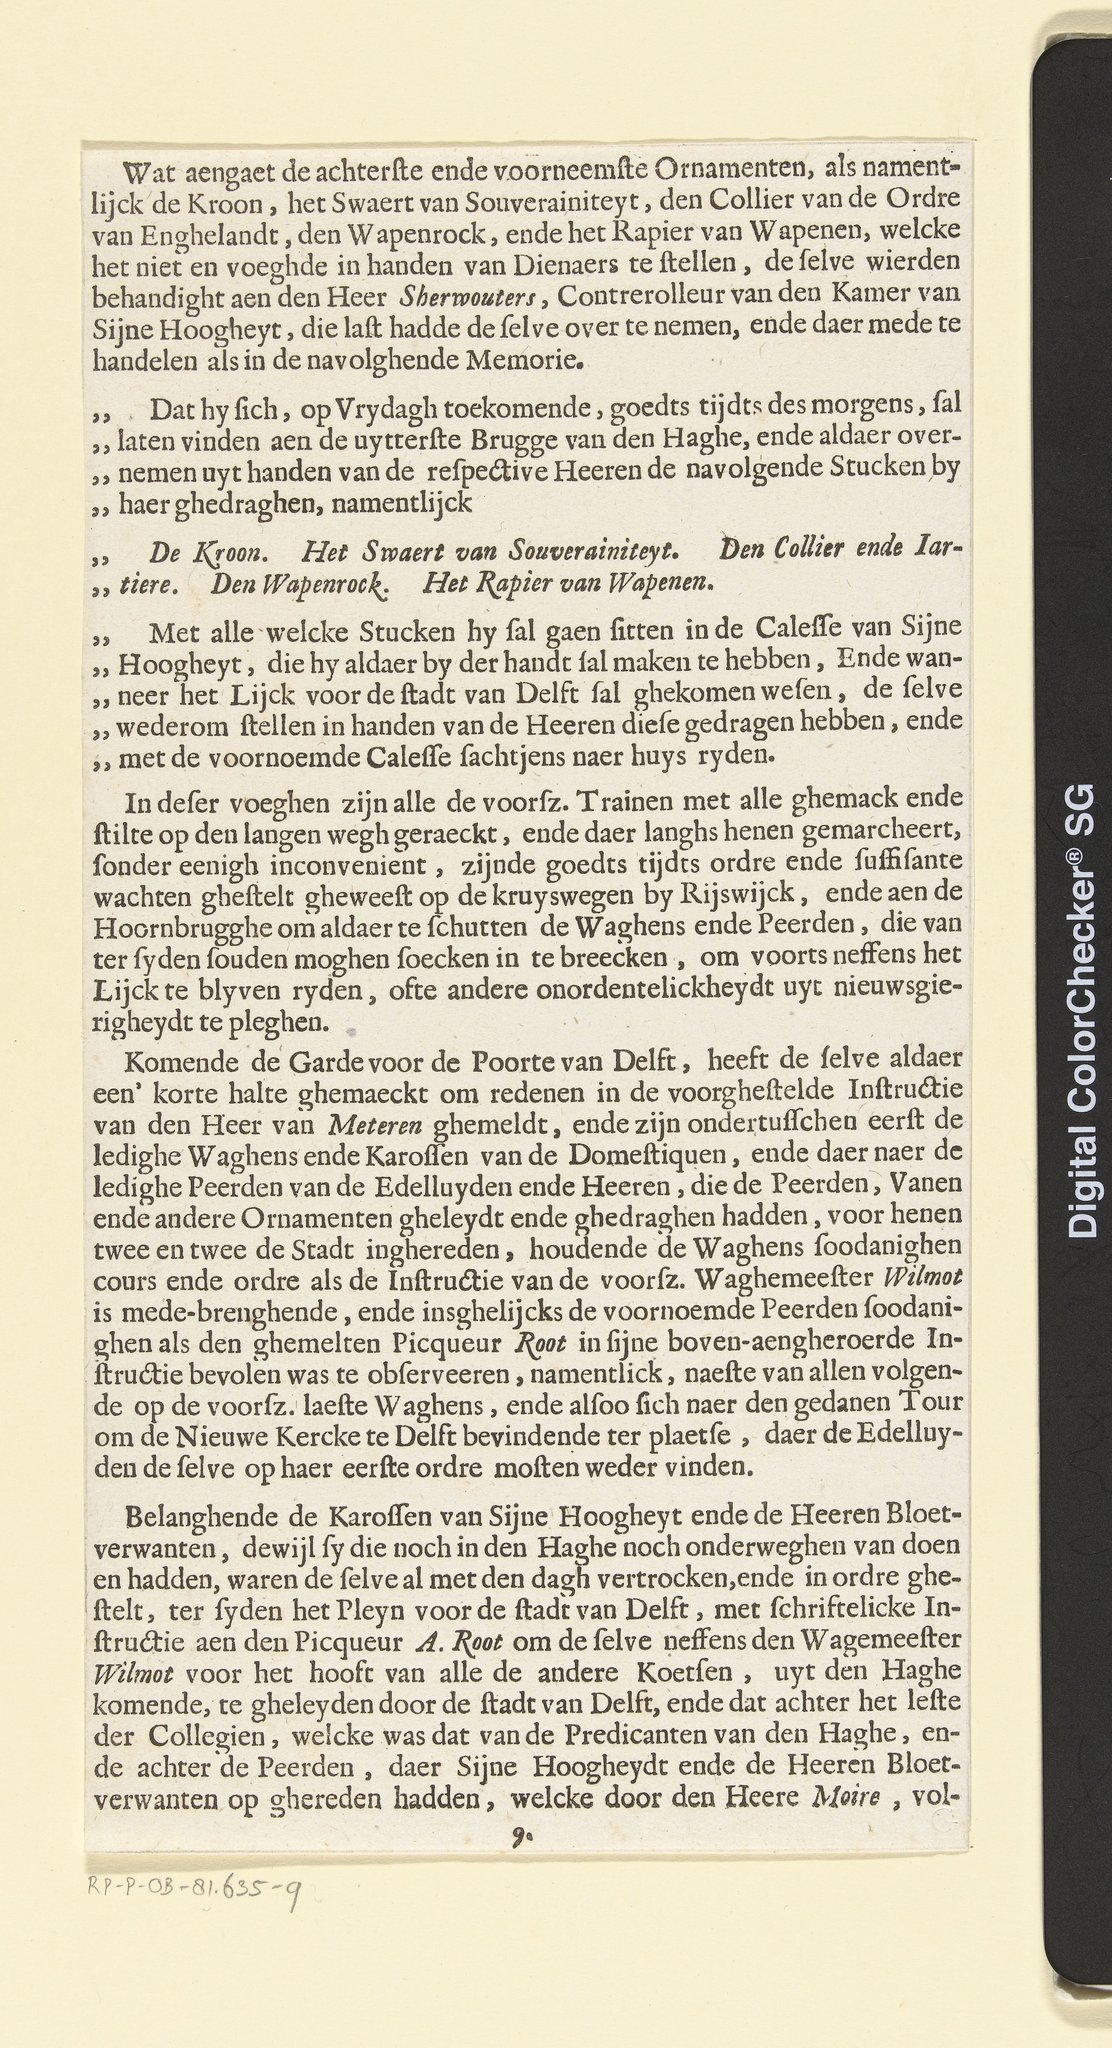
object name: text sheet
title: Begraeffenisse van Syne Hoogheyt Frederick Henrick, by der Gratien Gods Prince van Orange, Grave van Nassau &c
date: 1651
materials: paper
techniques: letterpress printing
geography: amsterdam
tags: delft, frederick henry (prince of orange), the hague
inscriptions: collector's mark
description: Tekstblad nr. 9 bij de prentserie van de begrafenisstoet van stadhouder Frederik Hendrik te 's-Gravenhage op 10 mei 1647. Onderdeel van een serie van 30 platen en 20 tekstbladen, bedoeld om aan elkaar geplakt te worden.